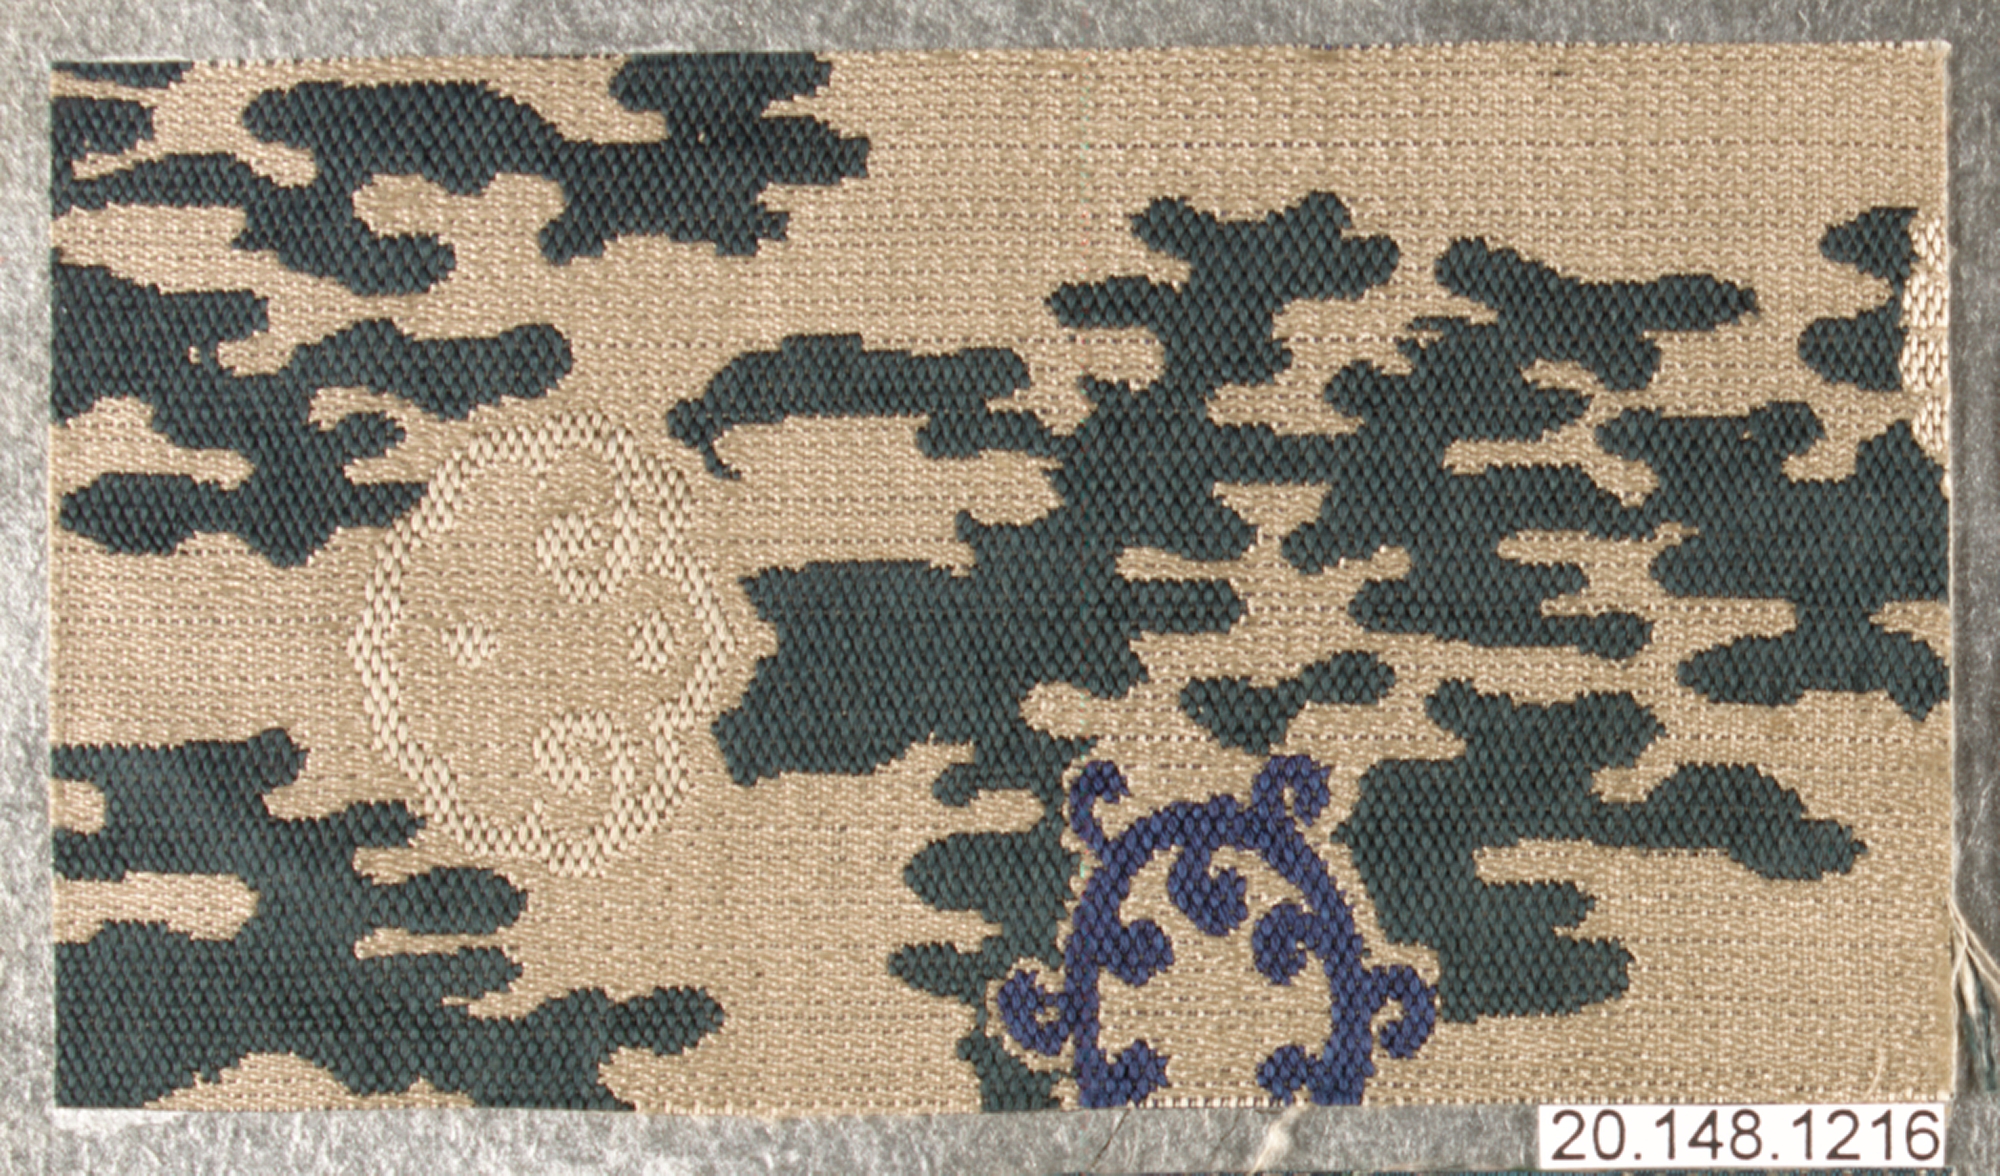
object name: piece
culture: japanese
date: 1801-1900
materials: silk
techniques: compound weave